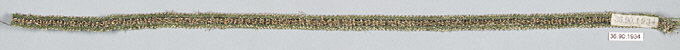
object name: galloon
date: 1601-1700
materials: metal thread, silk